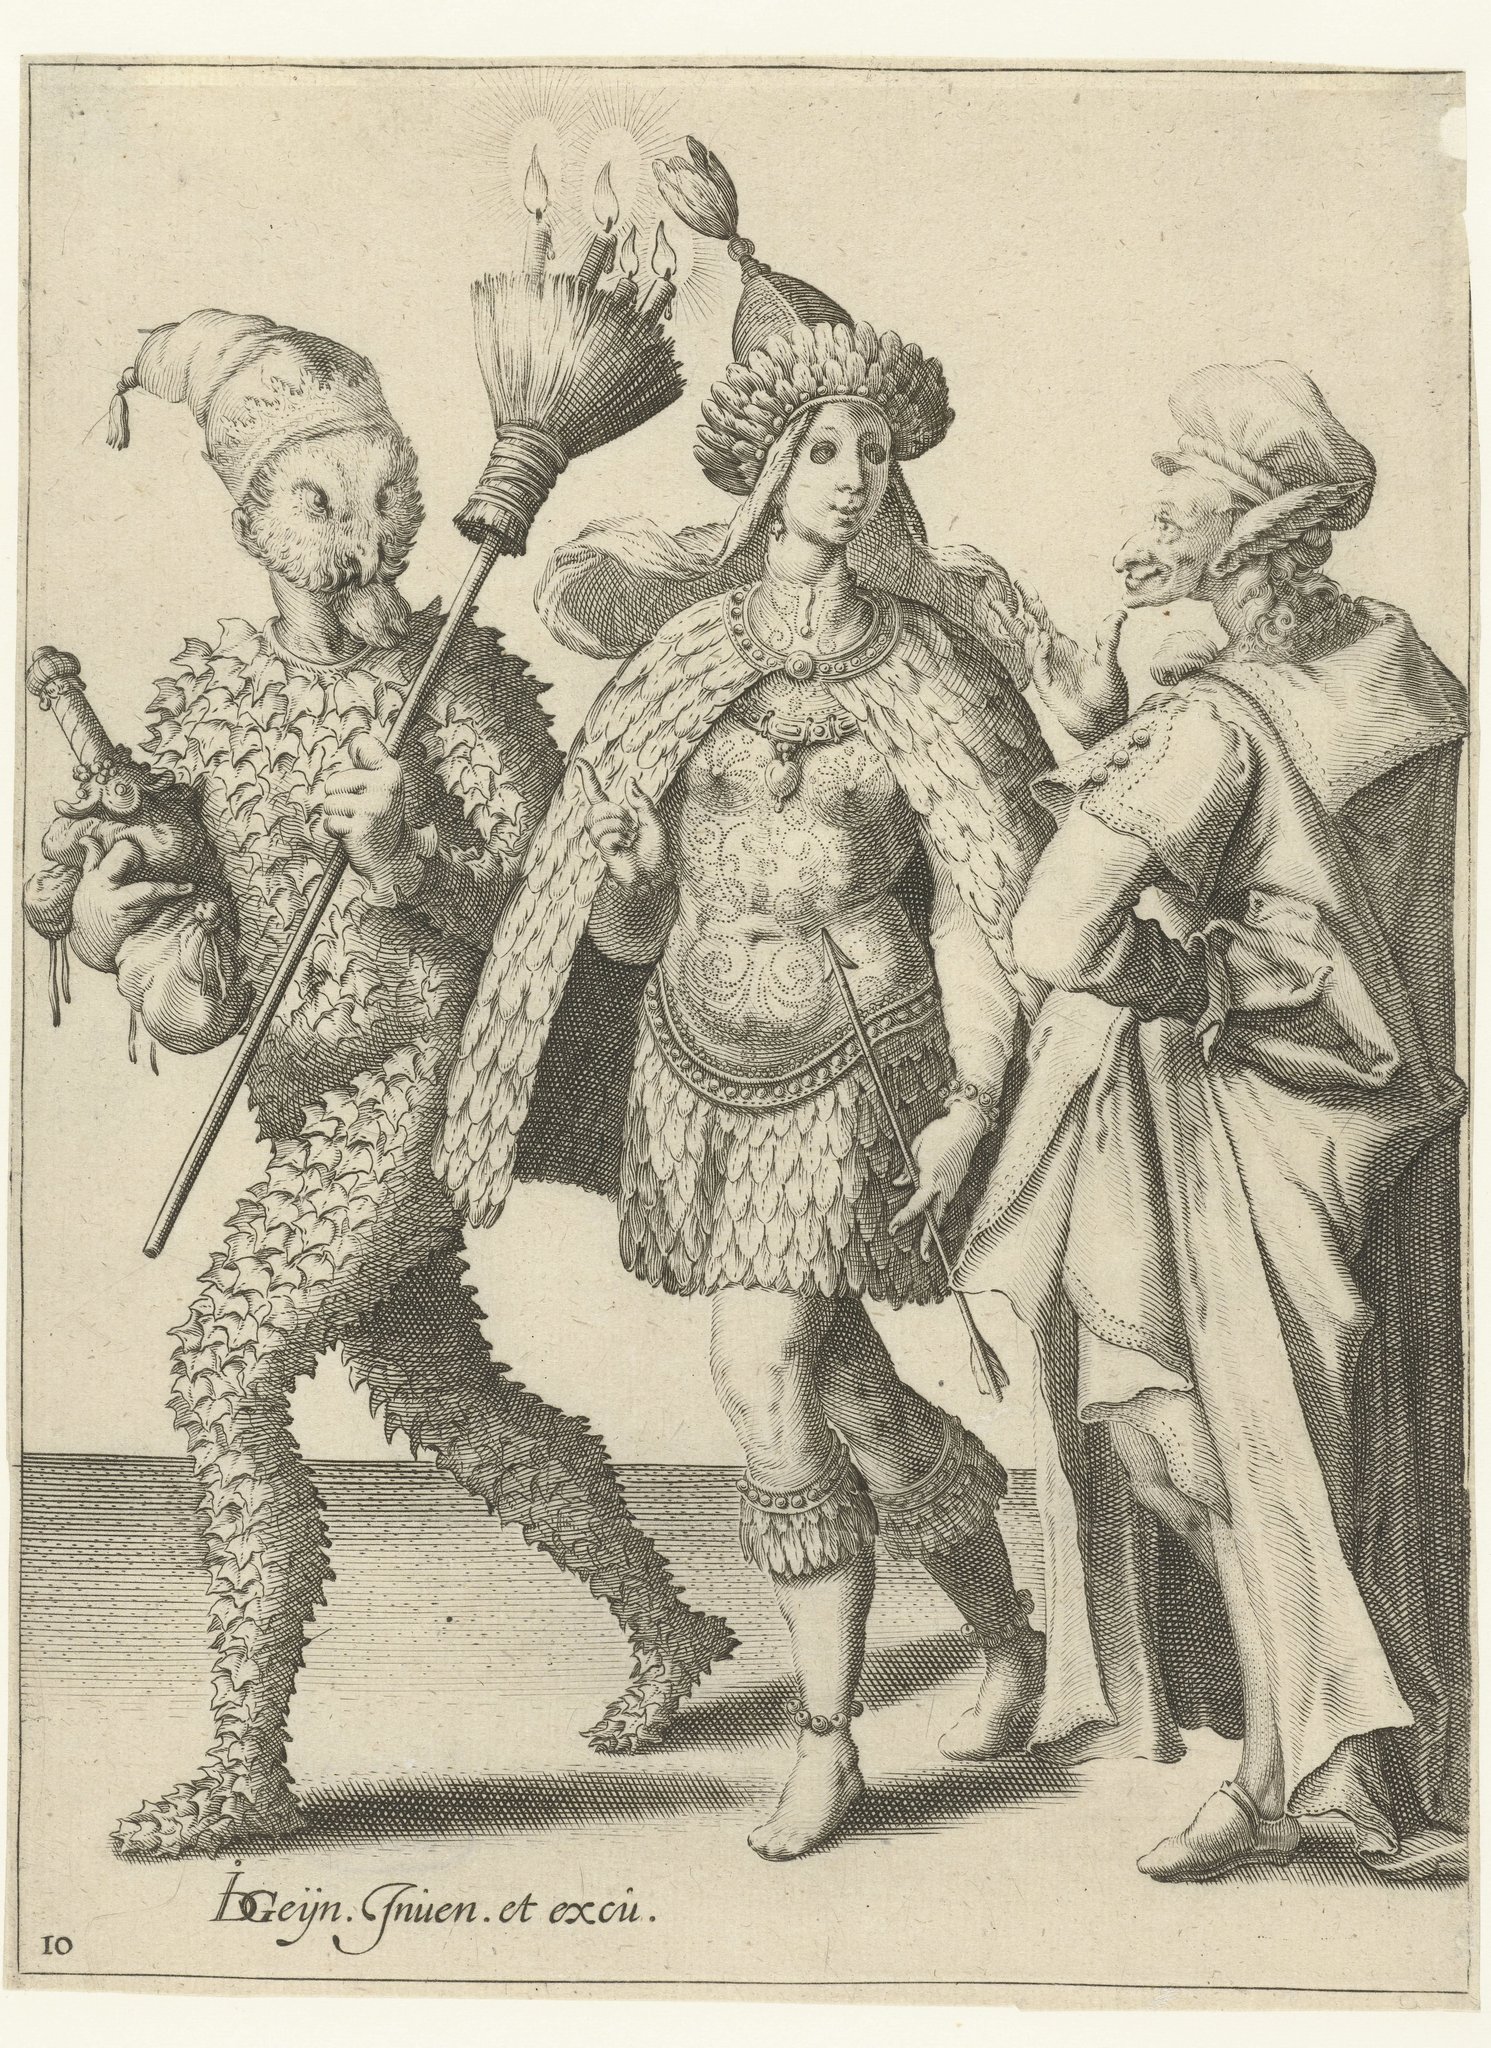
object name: print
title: Drie gemaskerde figuren, één van hen met een bezem waarin kaarsen zijn gestoken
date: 1595-1596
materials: paper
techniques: engraving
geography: netherlands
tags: mask, masquerade, masked ball, (household) utensils and implements (with name), candlestick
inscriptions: collector's mark: Lugt 2228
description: Een gemaskerd stel - zij gehuld in een pak van veren, hij in een pak van blaadjes, een bezem met kaarsen in de ene hand, een stokbeurs (?) in de andere - in gesprek met een gemaskerde figuur in een lange jas. Deze prent is onderdeel van een serie van tien genummerde prenten: een titelprent en negen prenten waarop twee of drie gemaskerde en/of verklede figuren ten voeten uit zijn weergegeven.